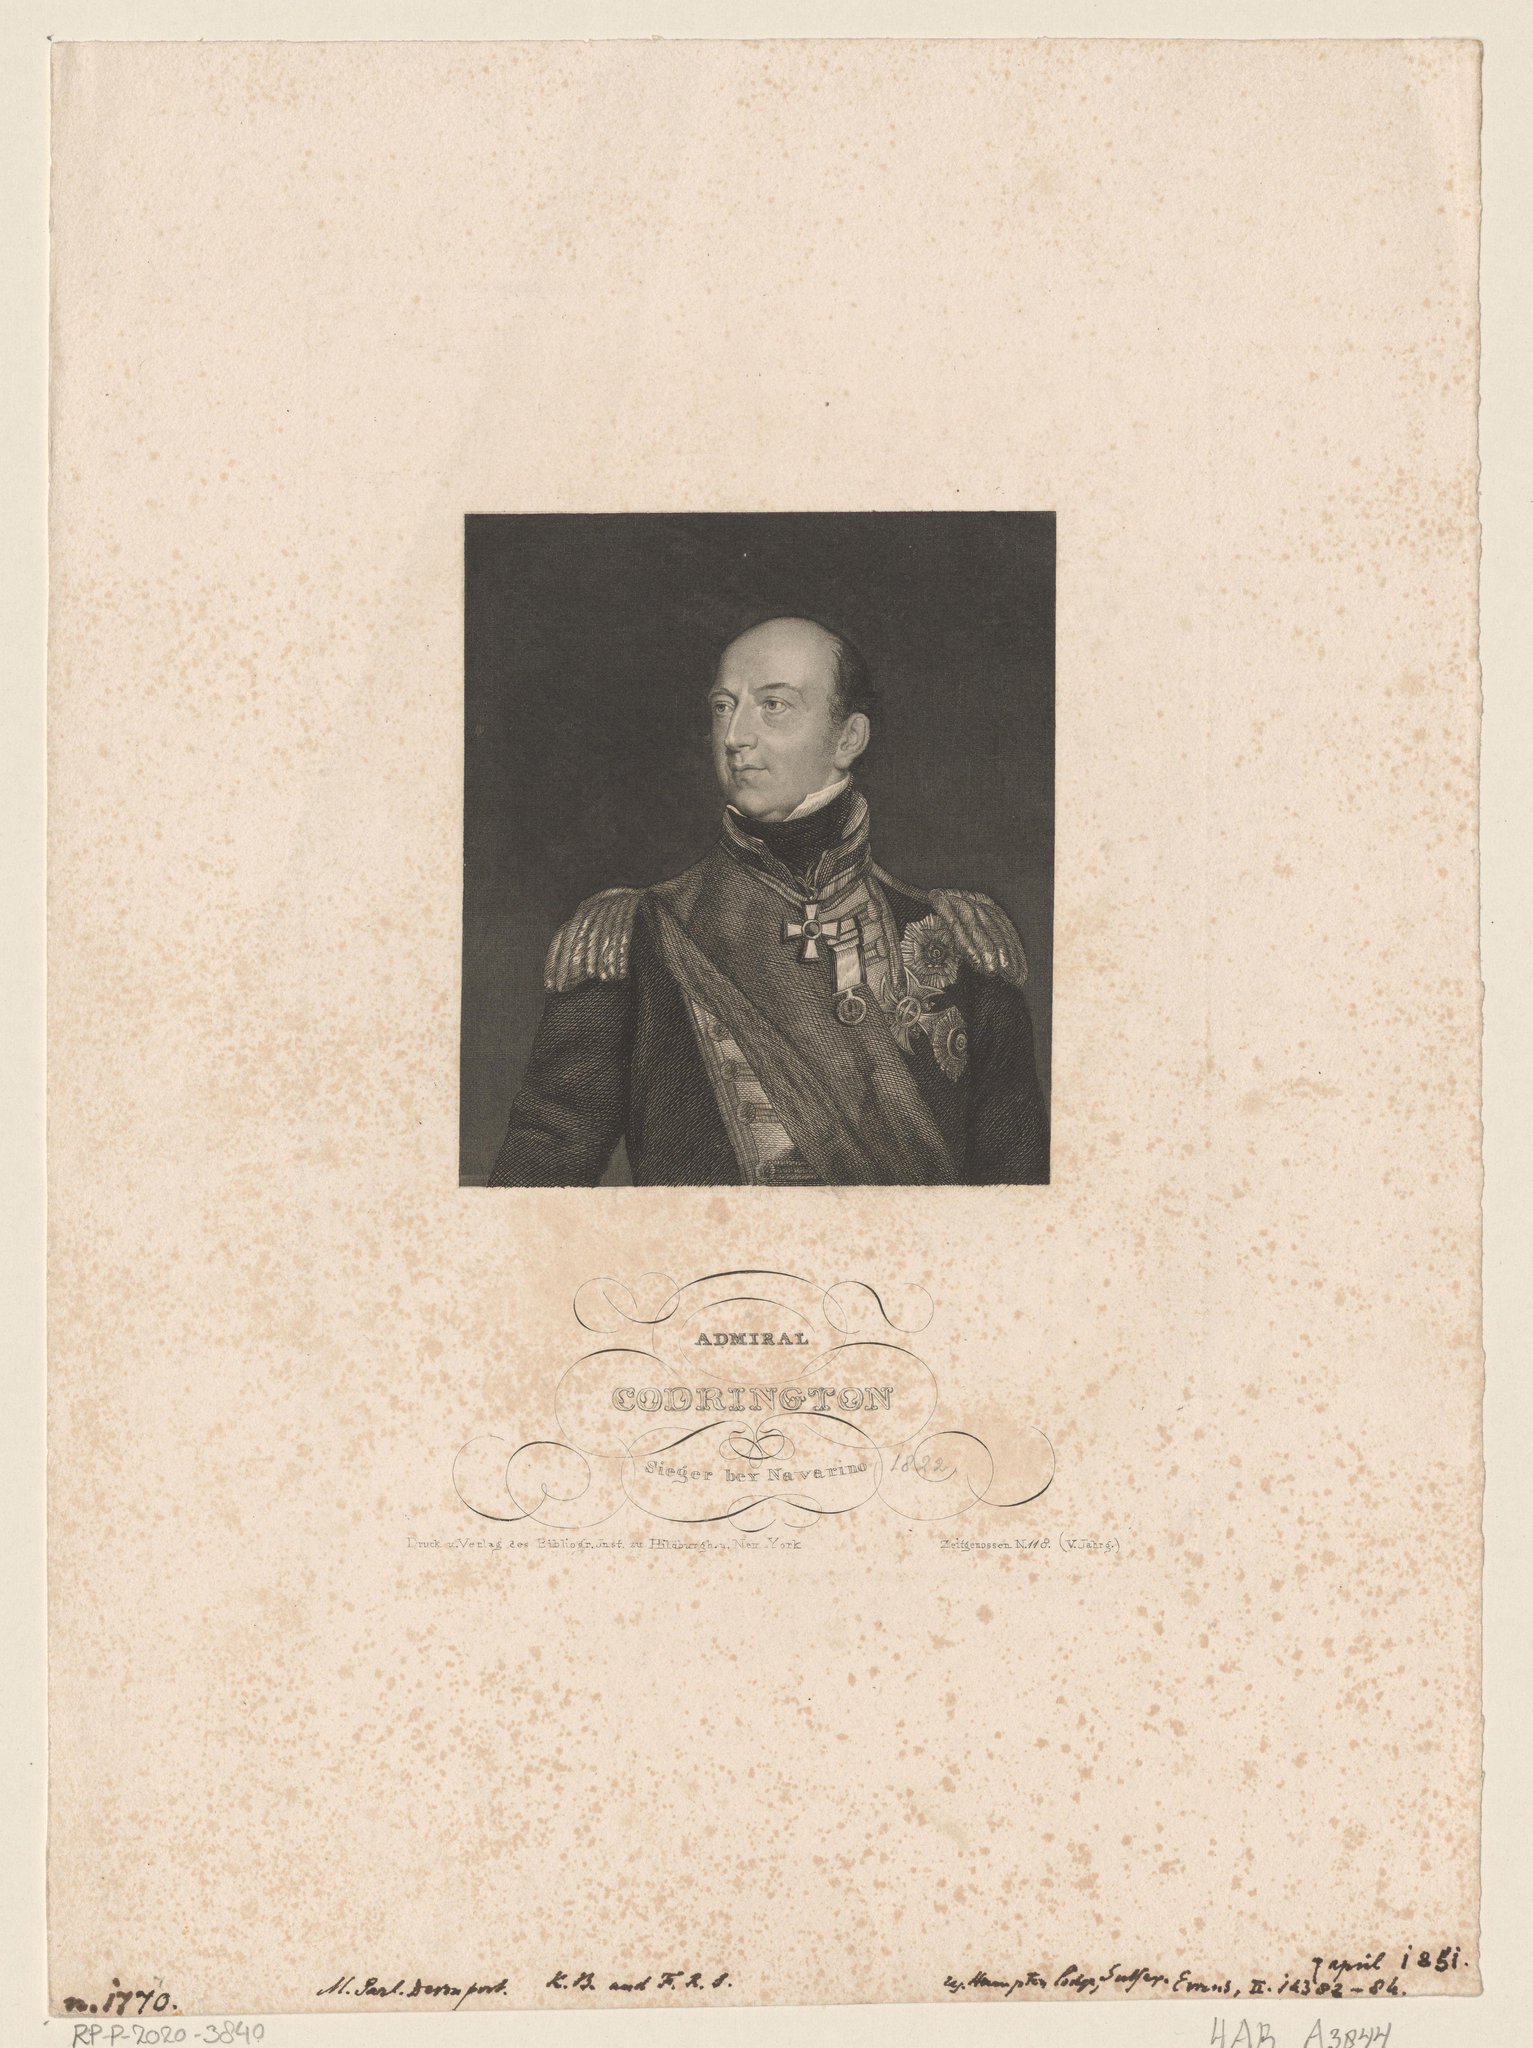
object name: print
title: Zeitgenossen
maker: Anonymous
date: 1829-1840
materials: paper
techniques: etching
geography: new york city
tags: historical persons, battle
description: Afkomstig uit de portretserie 'Zeitgenossen', uitgegeven tussen 1829 en circa 1840.